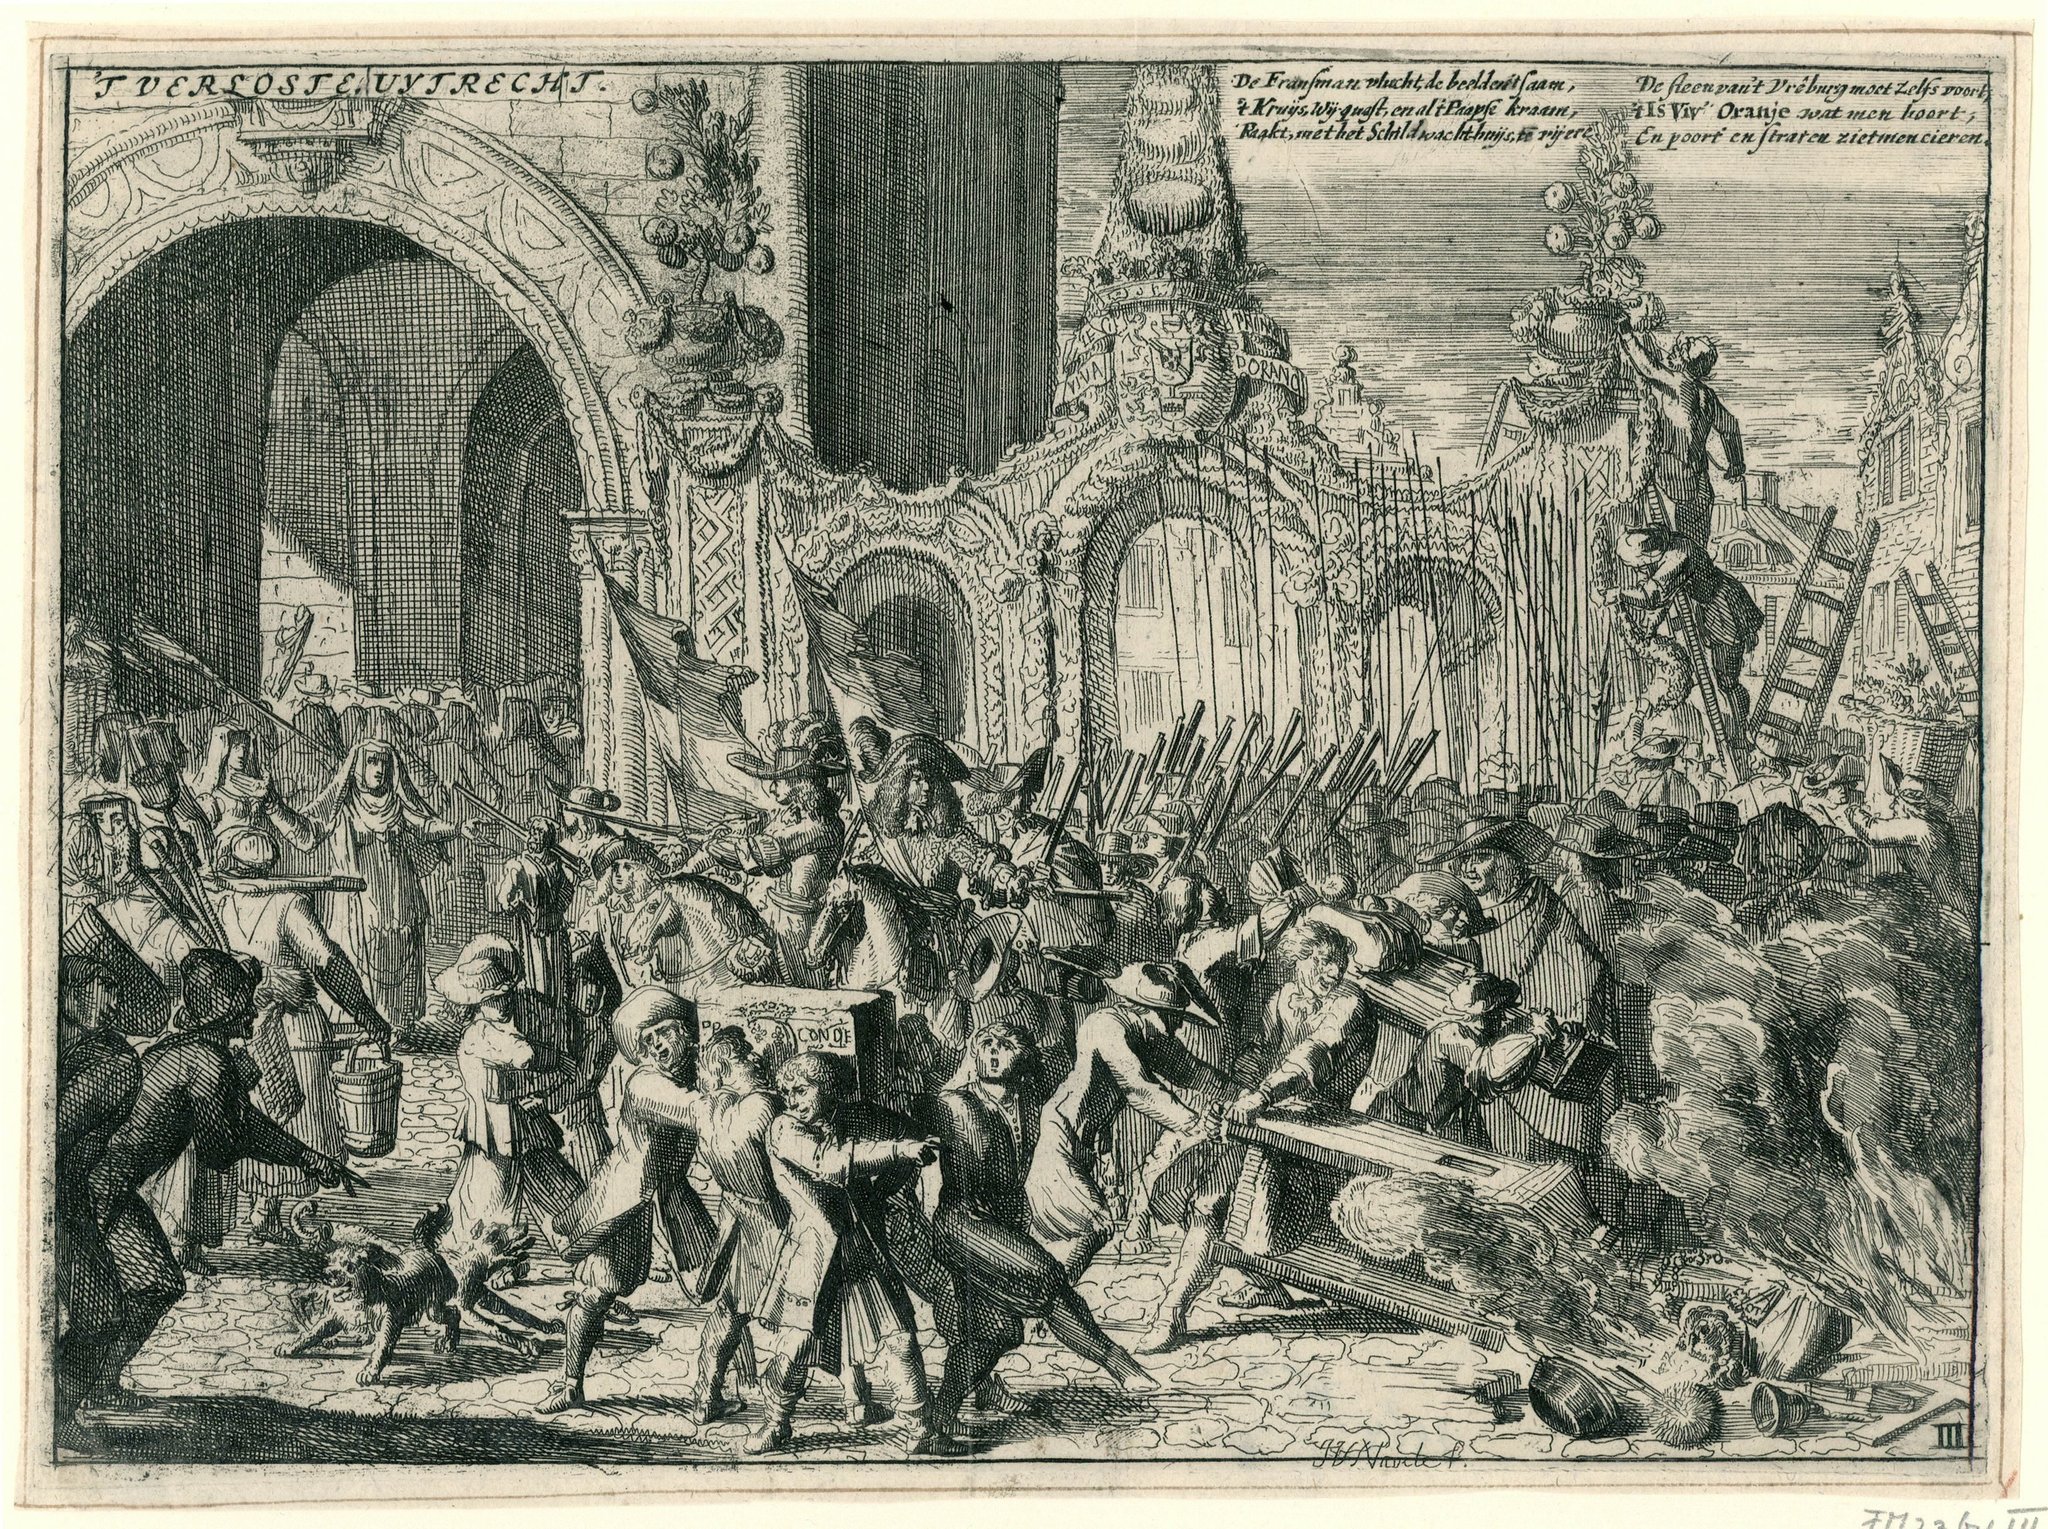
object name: print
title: Uytrechts Veranderingen Voorgevallen in de jaren 1672, 73 en 74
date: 1674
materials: paper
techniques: etching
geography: northern netherlands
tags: dom van utrecht, vertrek van de fransen uit utrecht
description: Het vertrek van de Fransen uit Utrecht op 23 november 1673. Op de voorgrond worden alle katholieke attributen die uit de Dom zijn verwijderd verbrand. Links trekken vrouwen met bezems en dweilen de kerk in om deze weer schoon te maken. Op de achtergrond worden triomfbogen voor de prins van Oranje opgericht. Rechtsboven twee drieregelige verzen in het Nederlands. Derde prent in een reeks van vijf prenten over de gebeurtenissen voorgevallen in Utrecht over de periode 1672-74.